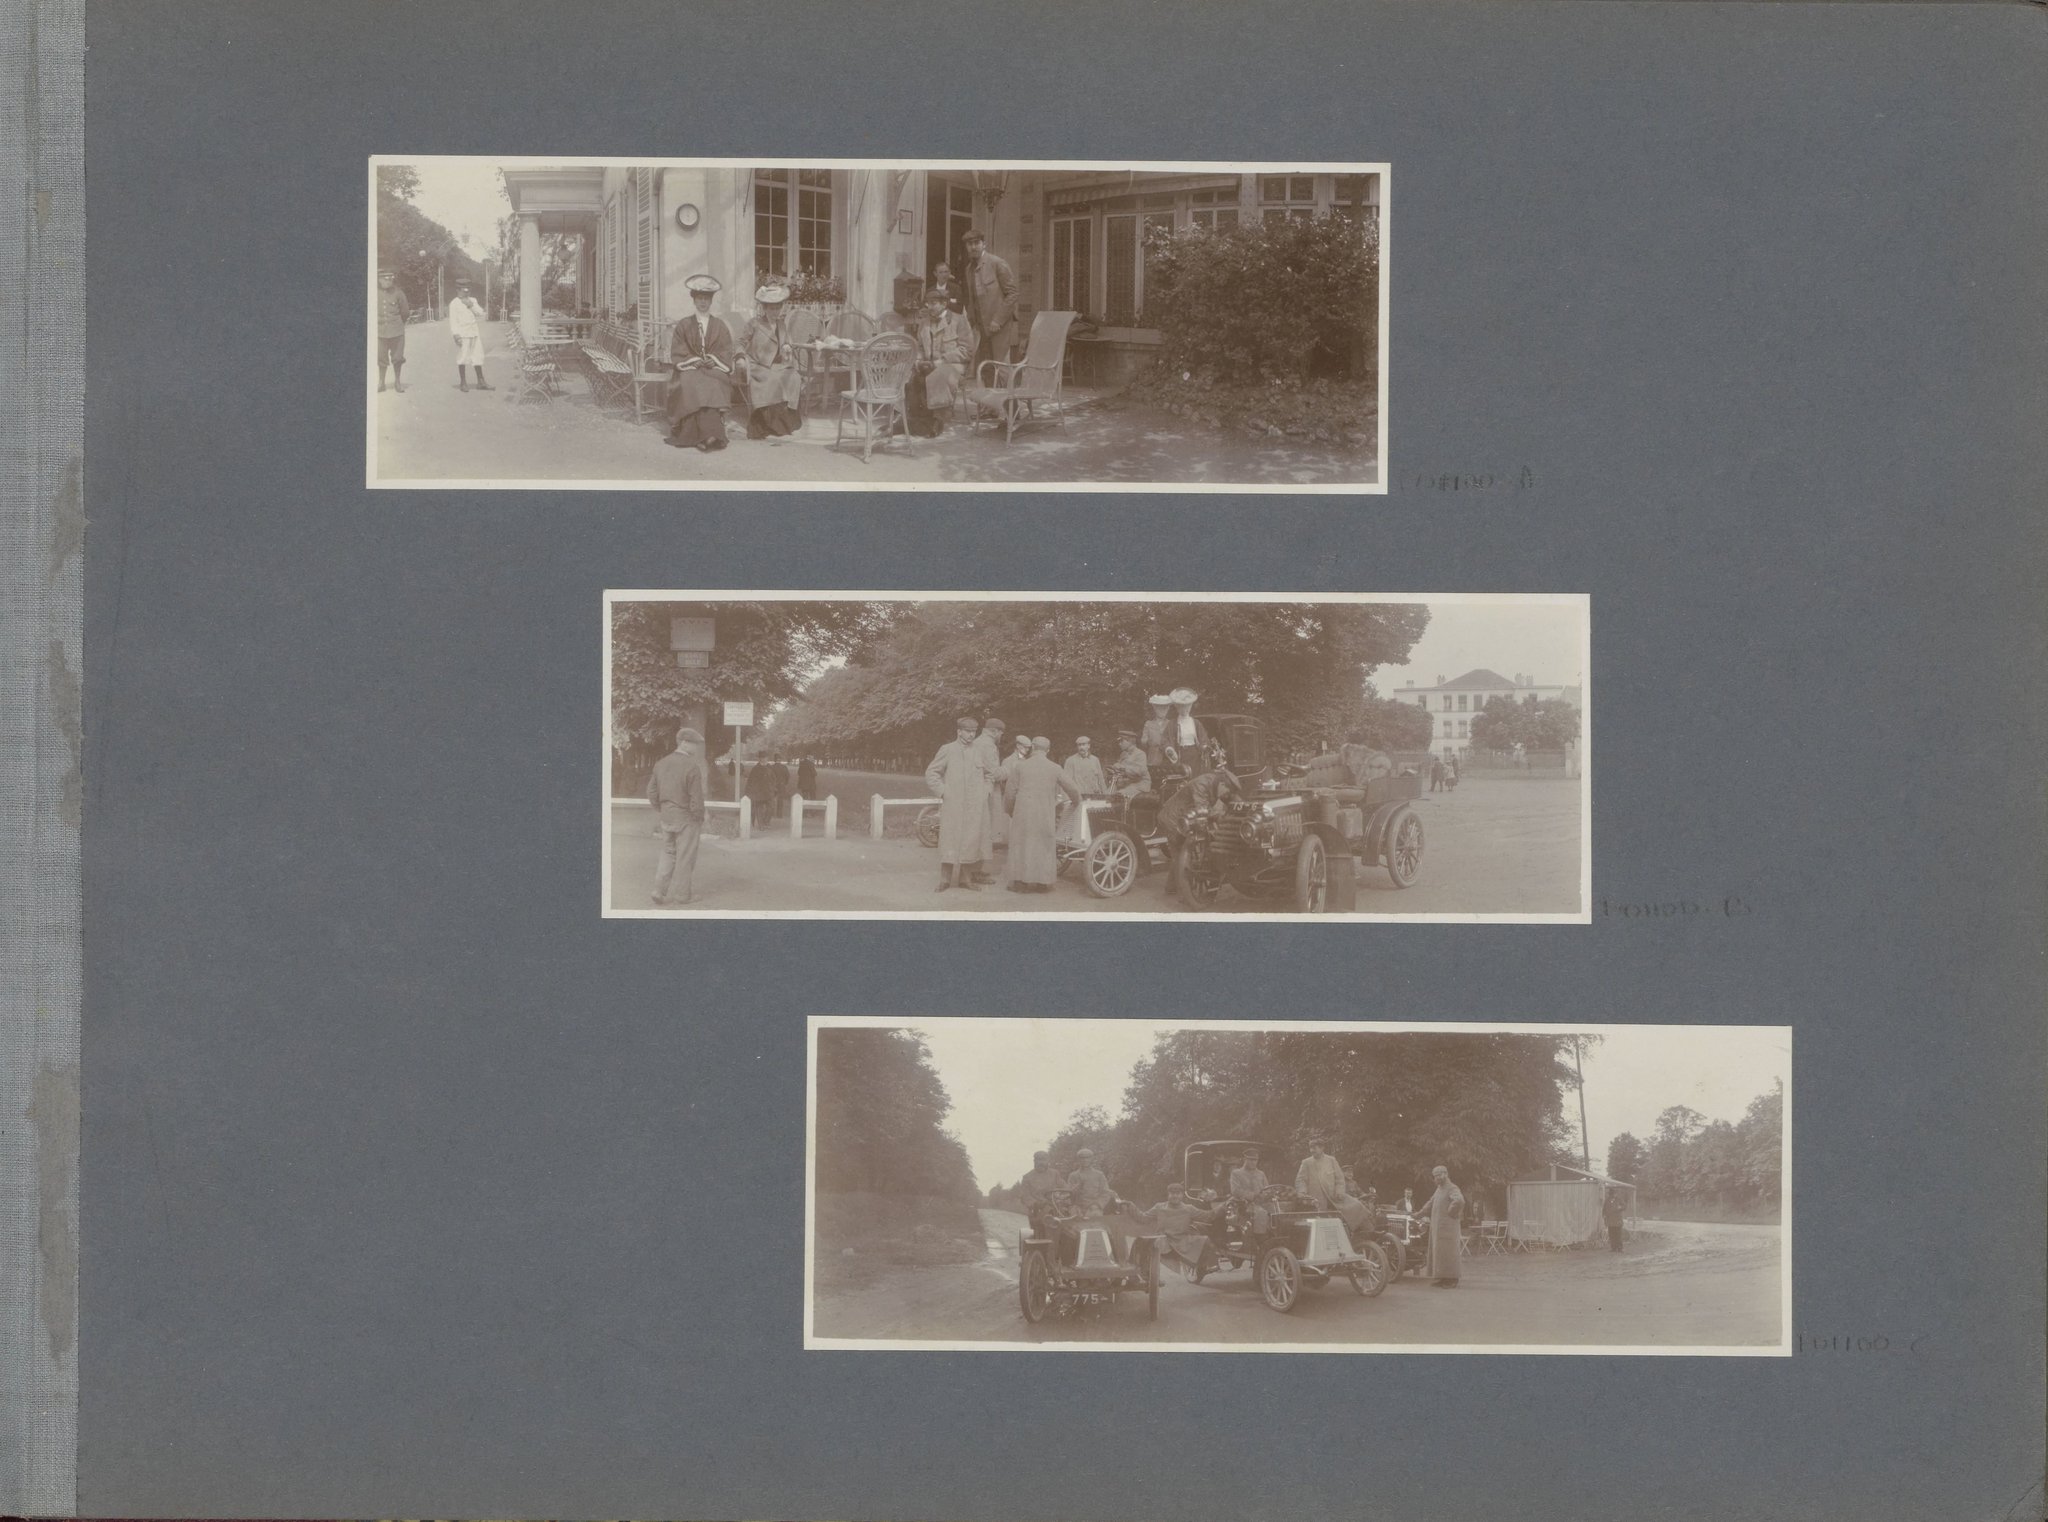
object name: photograph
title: Mannen en vrouwen op een terras in Frankrijk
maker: Anonymous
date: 1902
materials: paper, photographic support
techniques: daylight paper print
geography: france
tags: manoeuvre ~ military training, pavement, terrace in front of inn or restaurant, france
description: Onderdeel van Fotoalbum van een legeroefening in Zuidwest-Frankrijk in 1902.